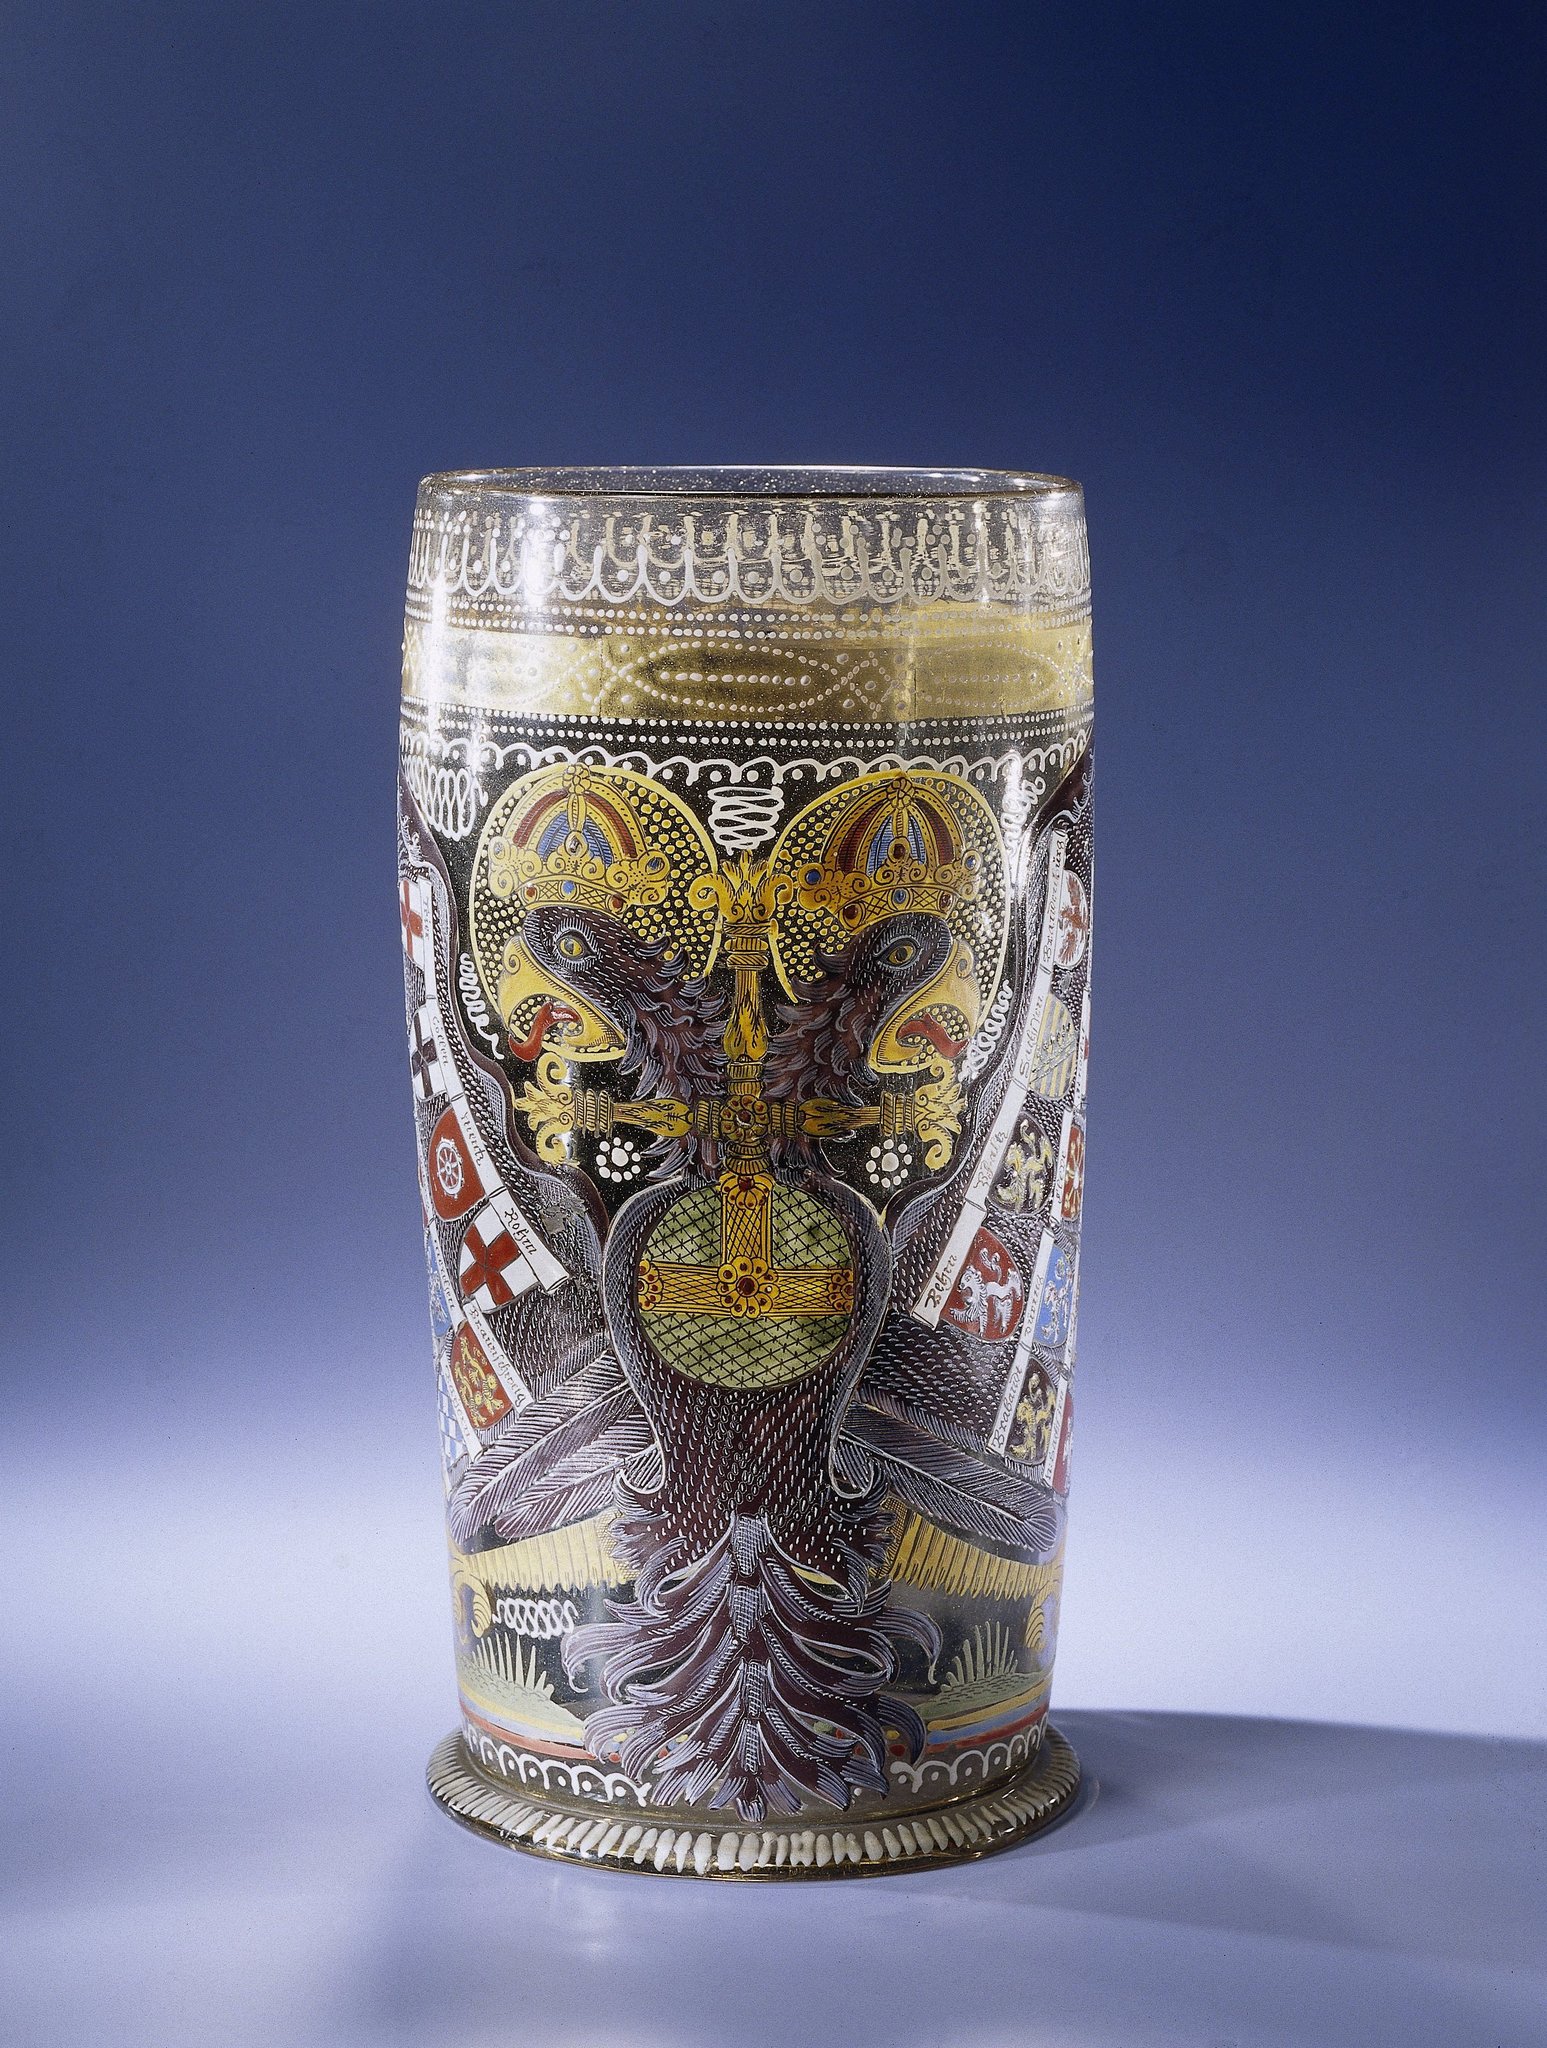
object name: reichsadlerhumpen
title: Reichsadlerhumpen (Imperial eagle beaker)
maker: Anonymous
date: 1649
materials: glass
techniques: glassblowing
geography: oberfranken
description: The coats of arms of the Electors and the Quaterniones Imperii (representatives of the German Empire) have nestled safely under the wings of he Holy Roman Emperor, who watches over them like an eagle. This presented an ideal image, however, for in reality there was little unity in the onflict-ridden empire in the 17th century. At the same time, this made it a popular toasting motif.